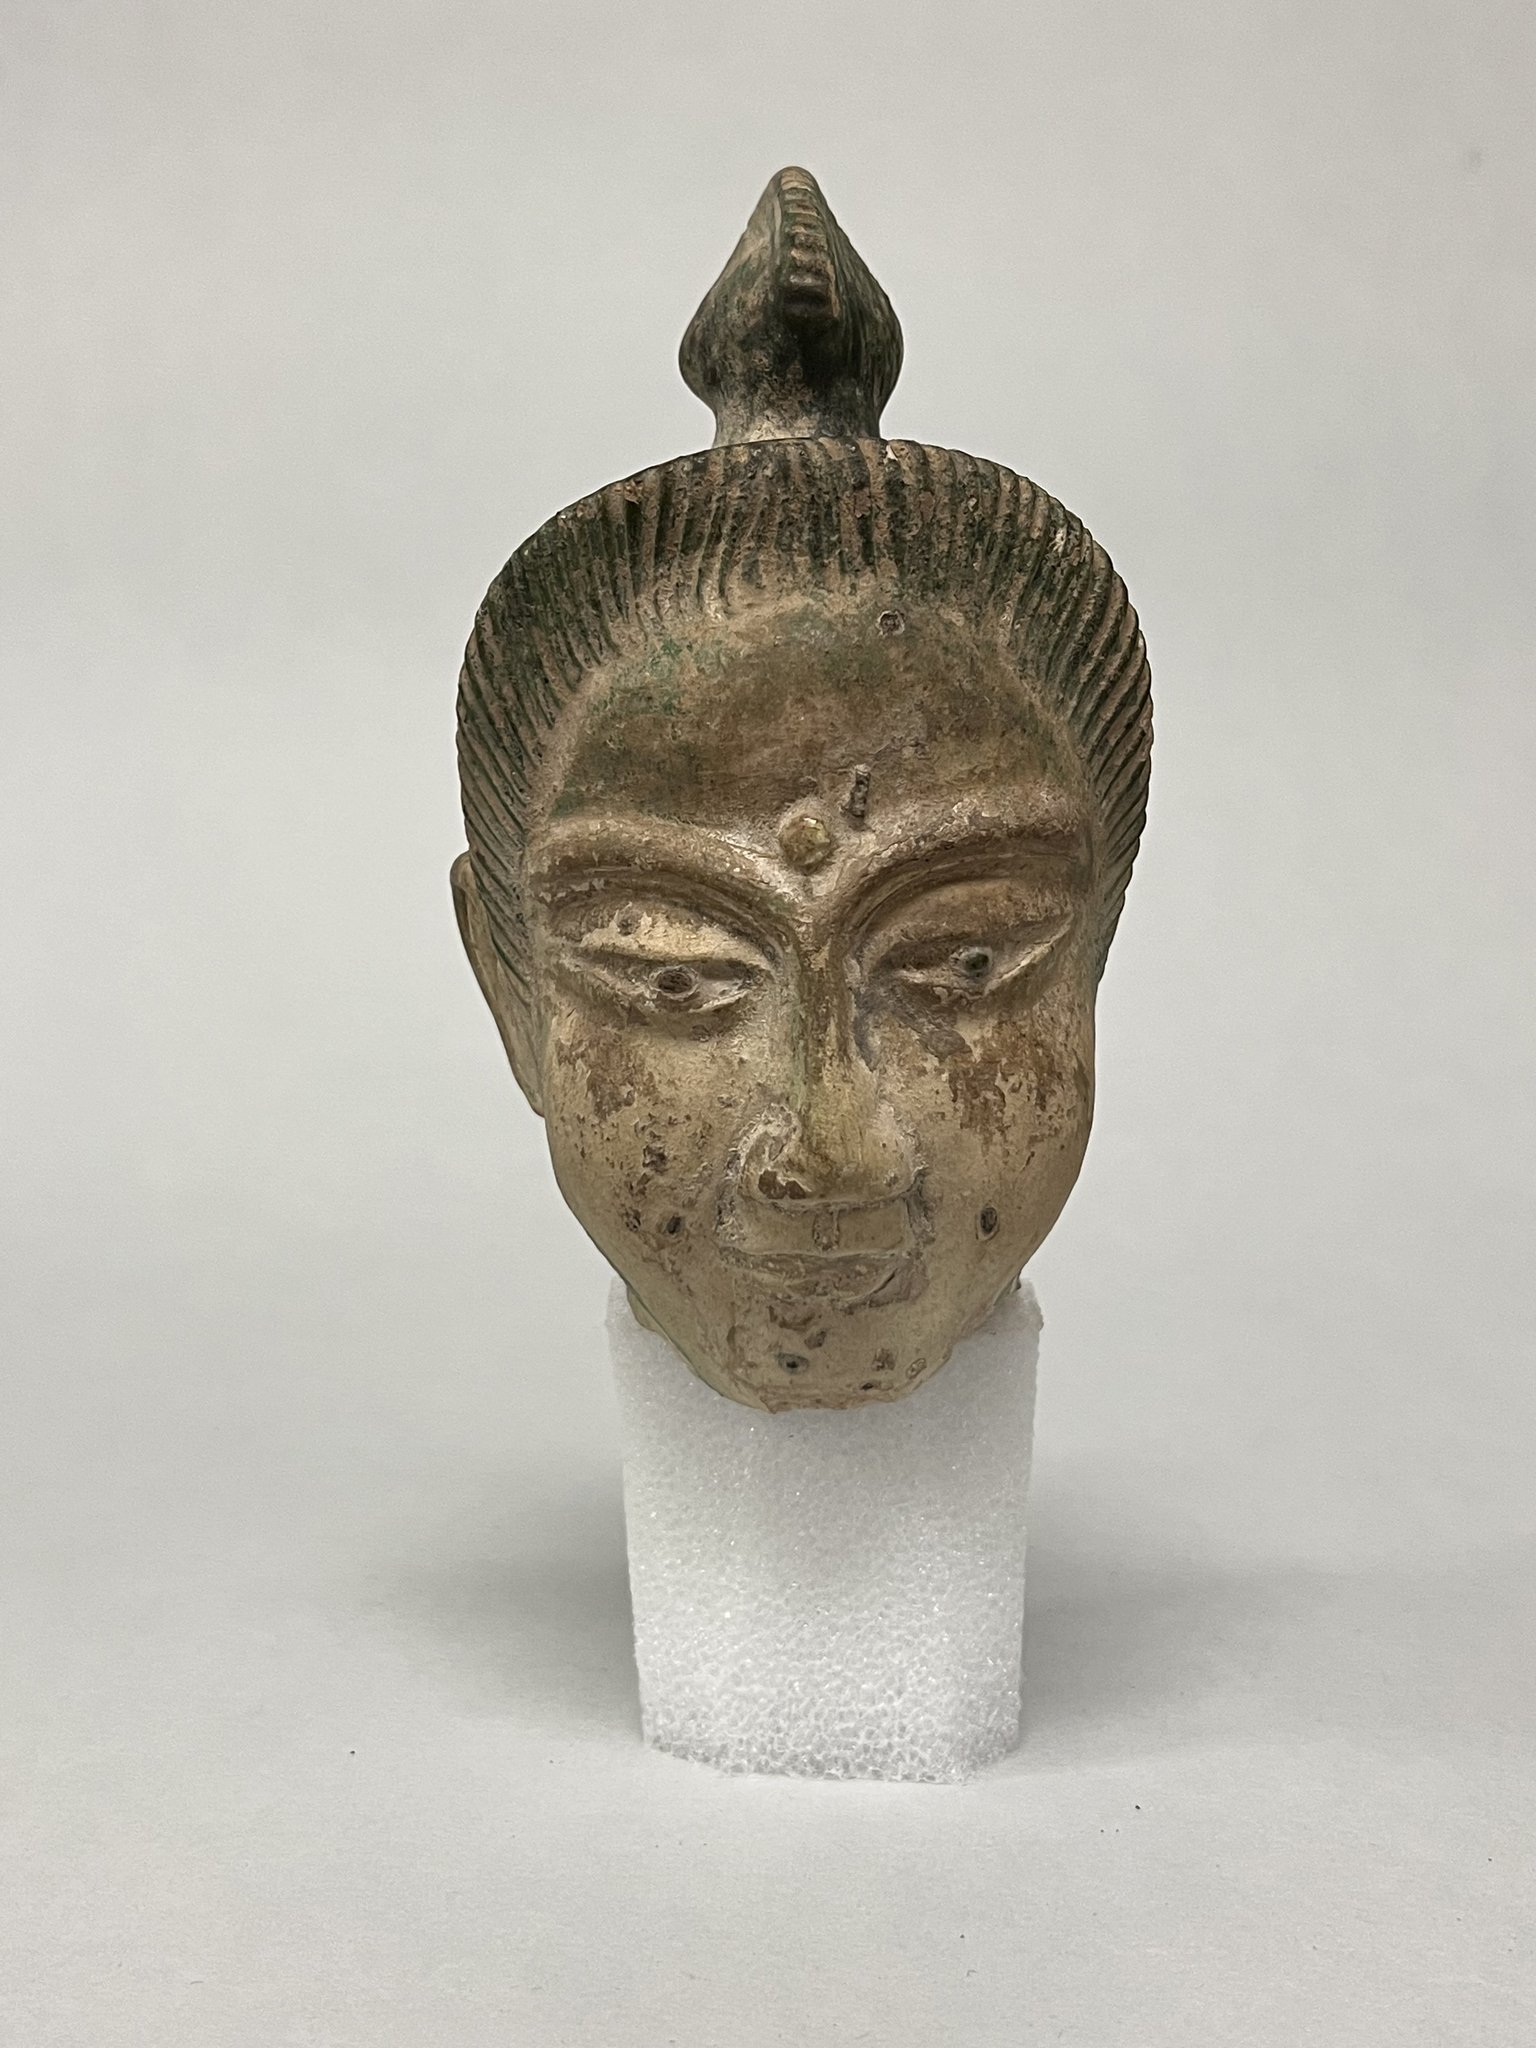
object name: head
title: Head of a Bodhisattva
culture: chinese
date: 617-907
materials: earthenware, glaze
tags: heads,bodhisattvas